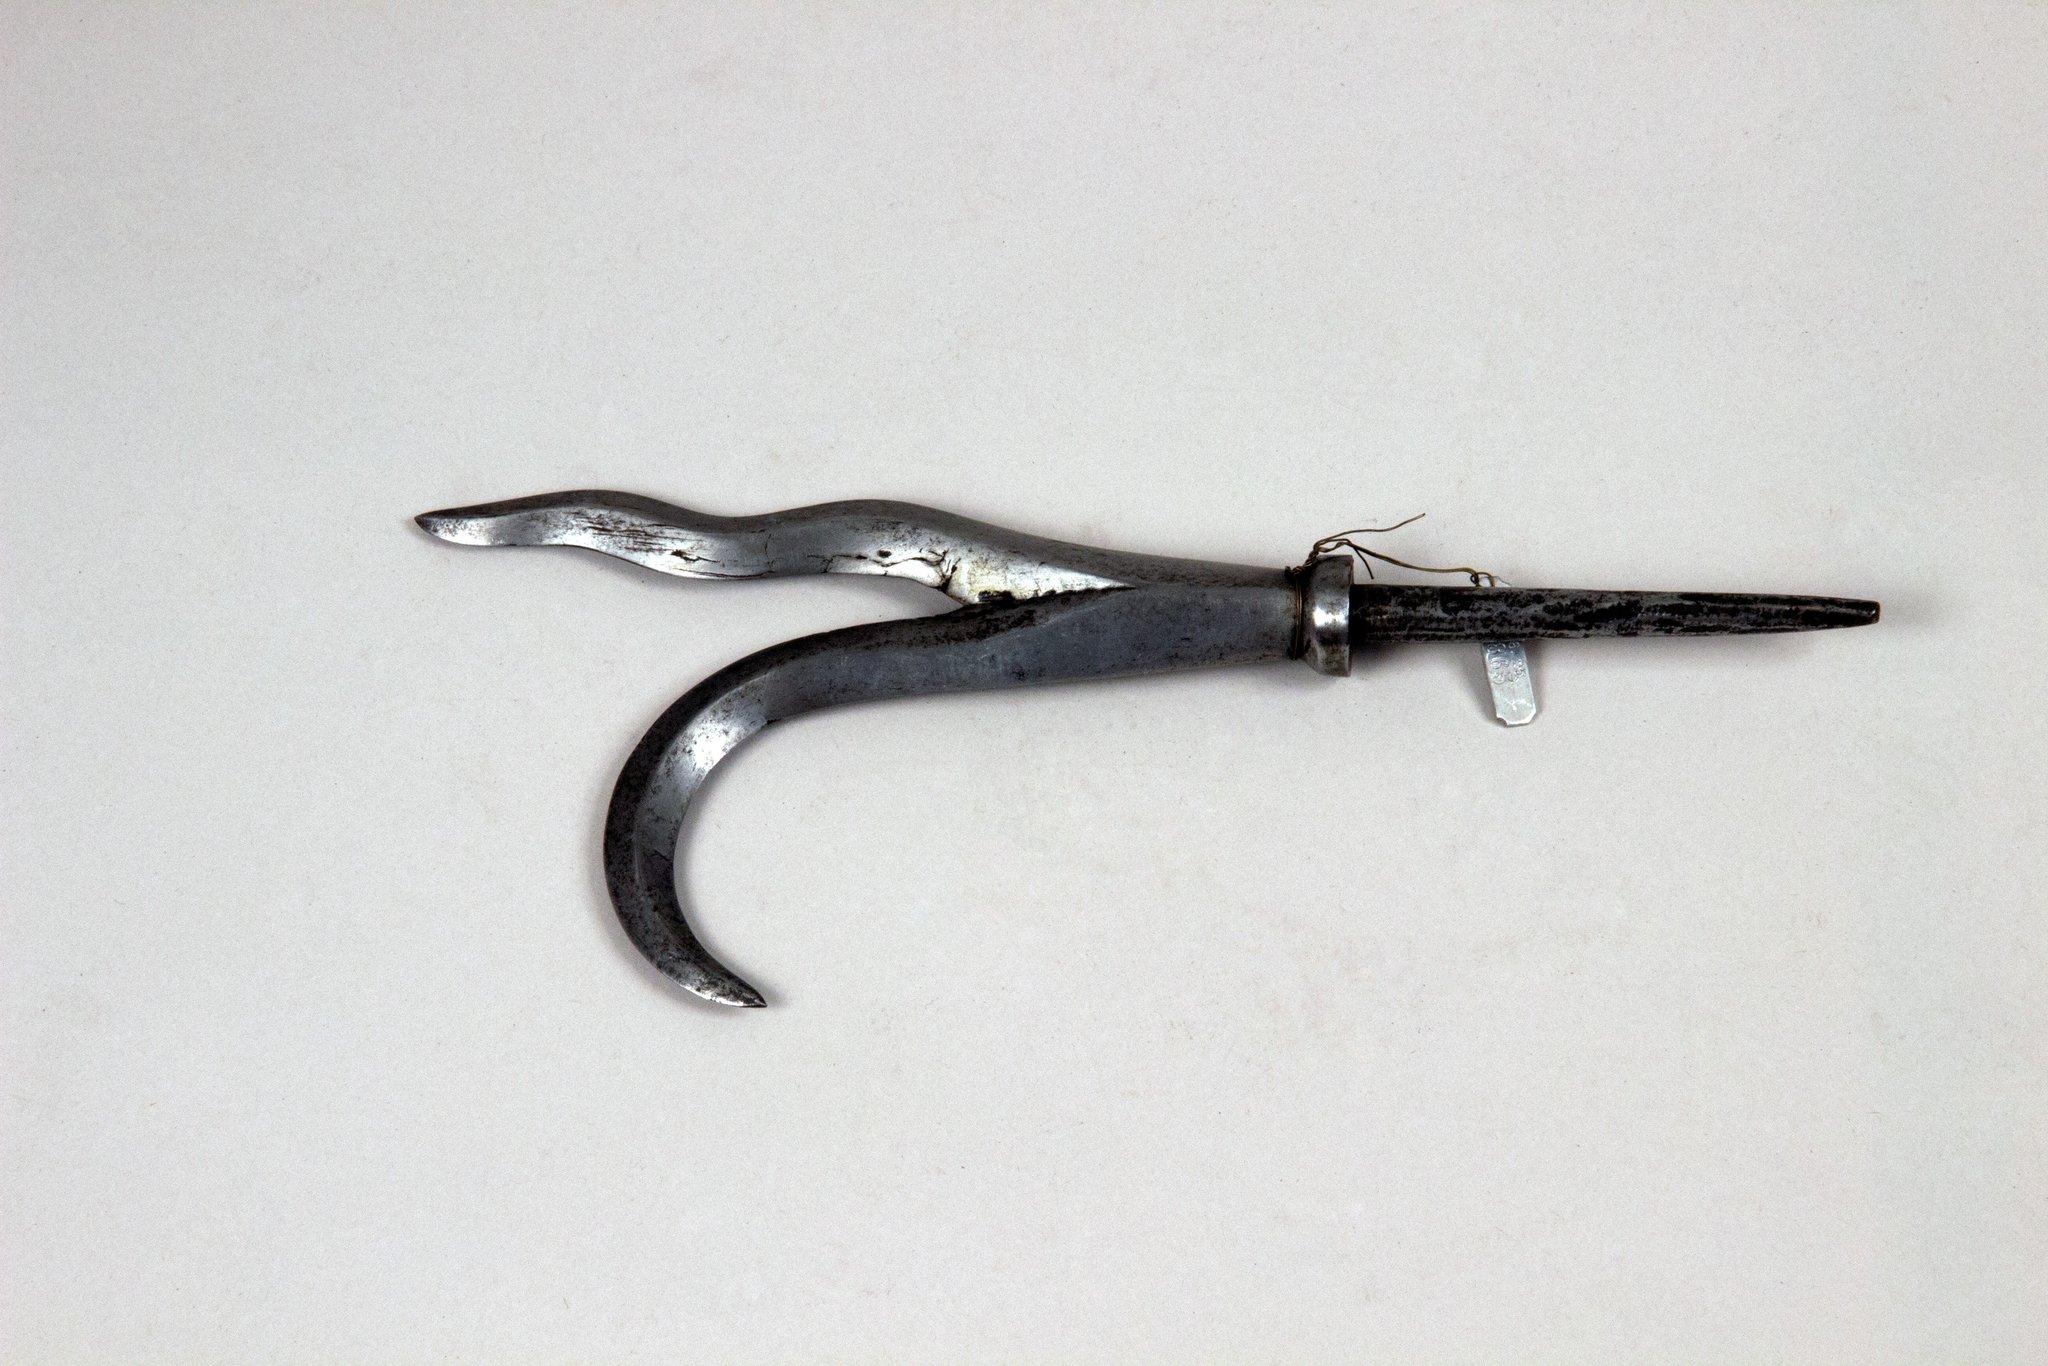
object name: ancus head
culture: javanese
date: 1501-1900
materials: steel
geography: indonesia